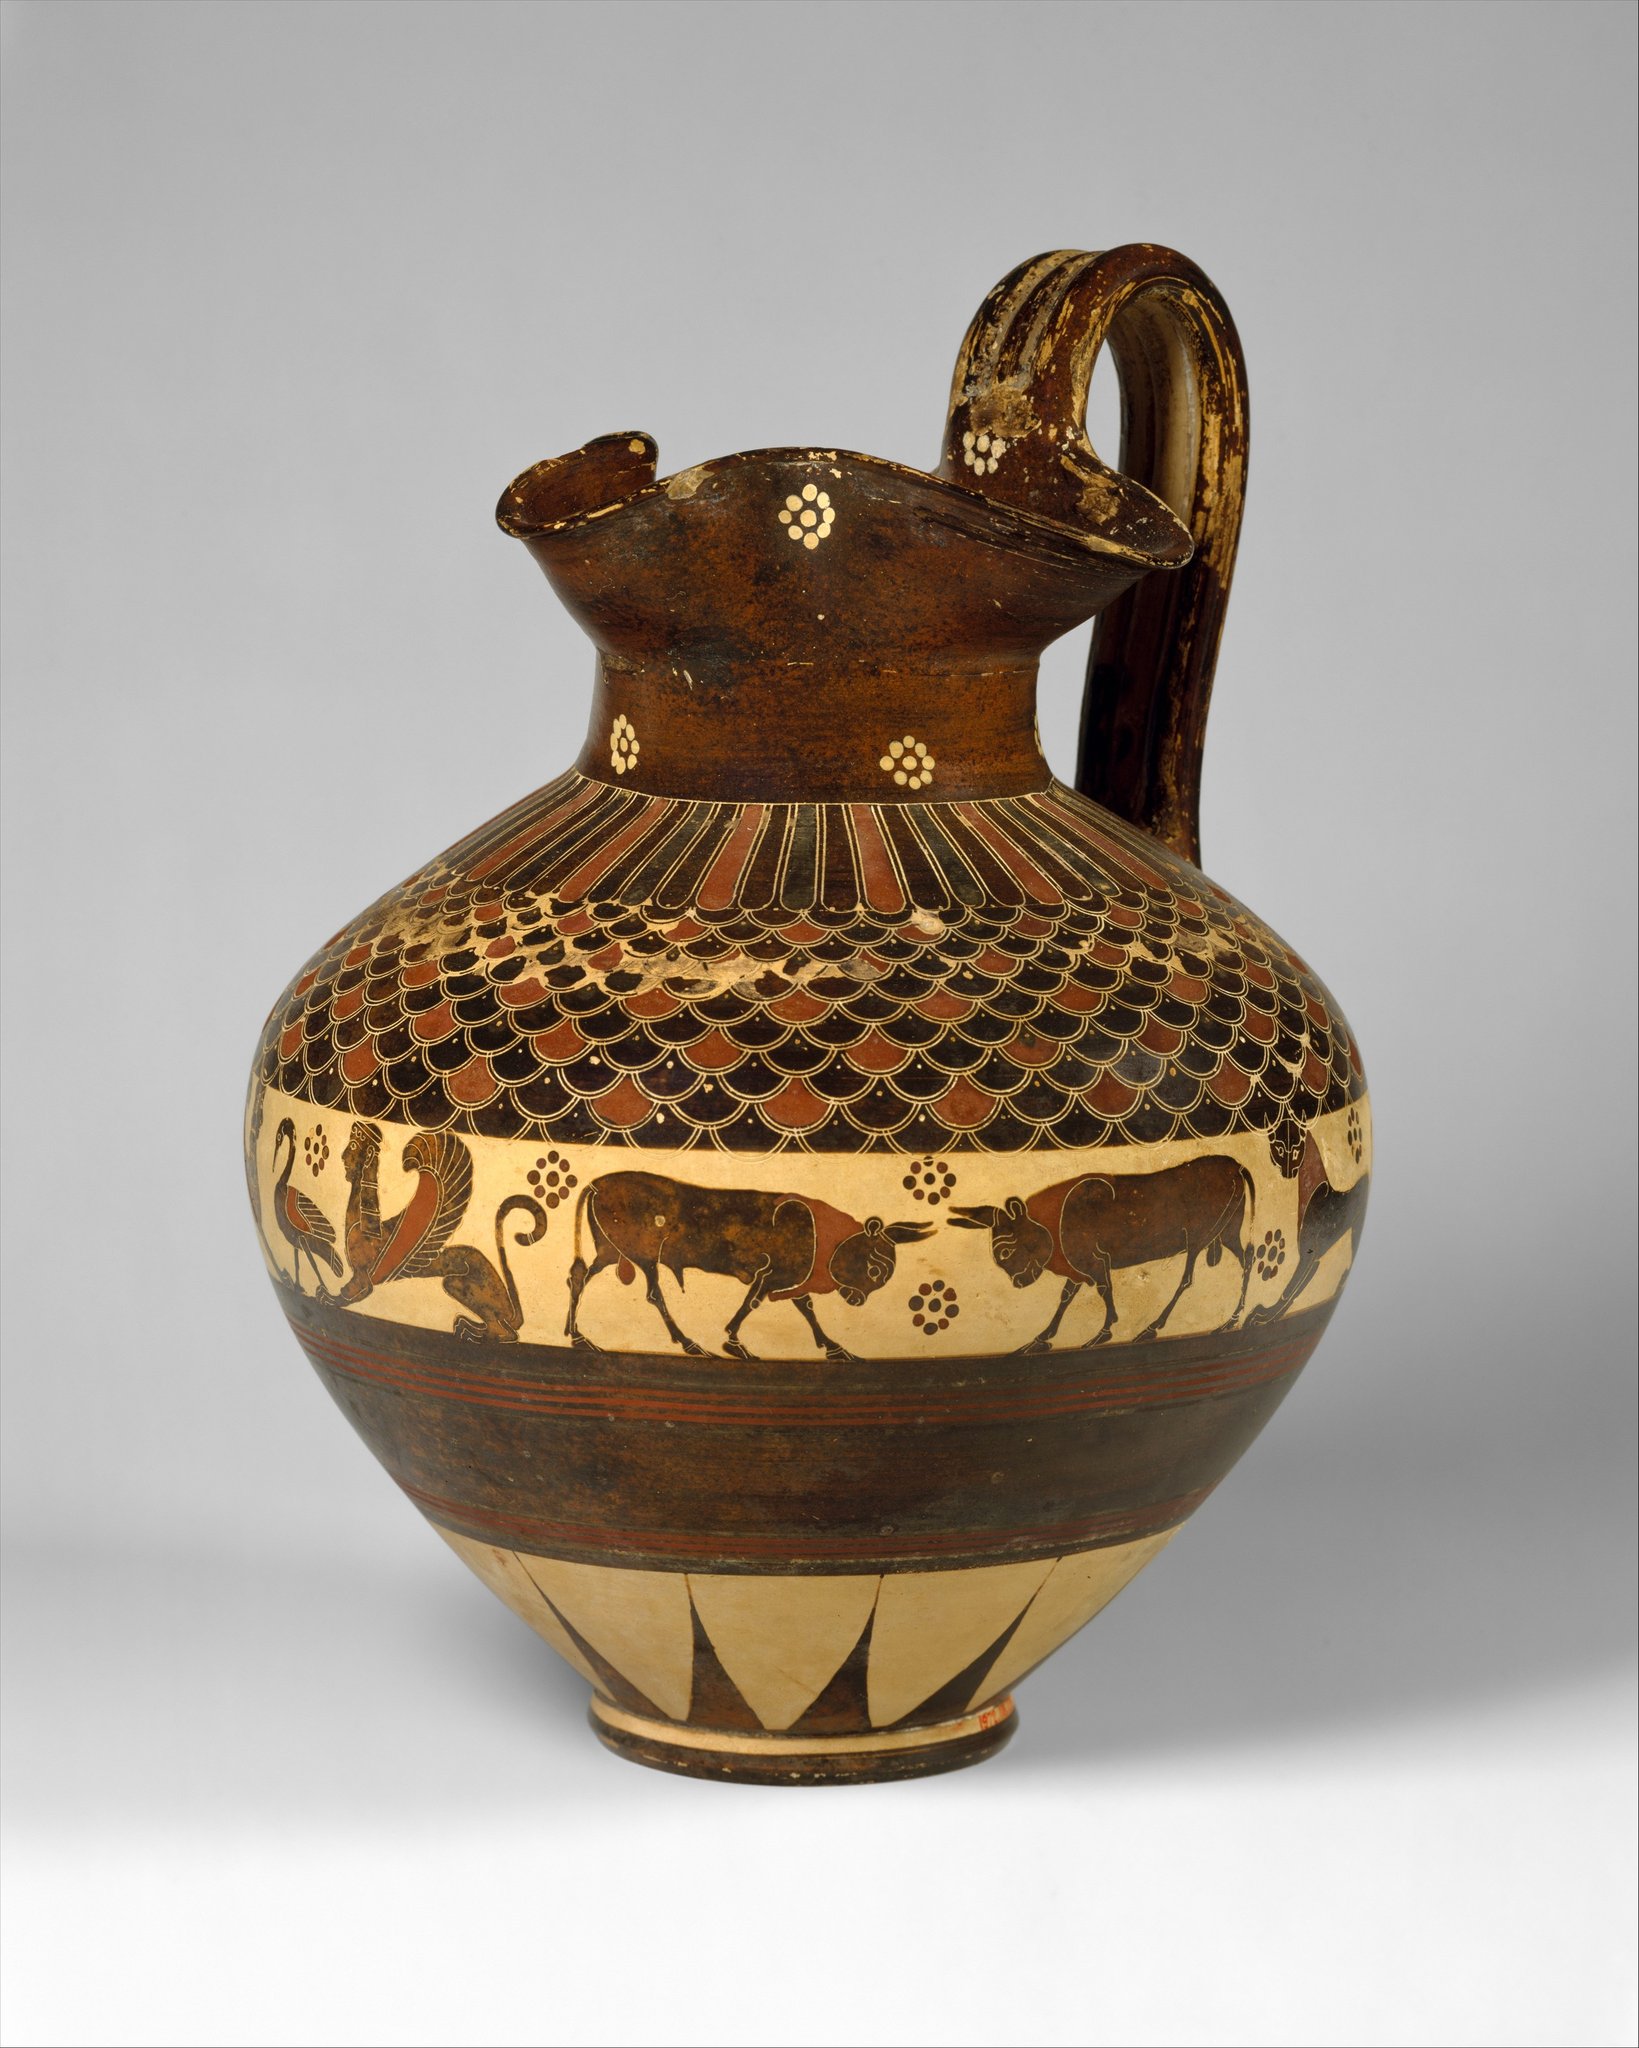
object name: oinochoe, trefoil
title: Terracotta oinochoe (wine jug)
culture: greek, corinthian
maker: chigi group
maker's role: artist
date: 625 BCE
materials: terracotta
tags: birds,bulls,lions